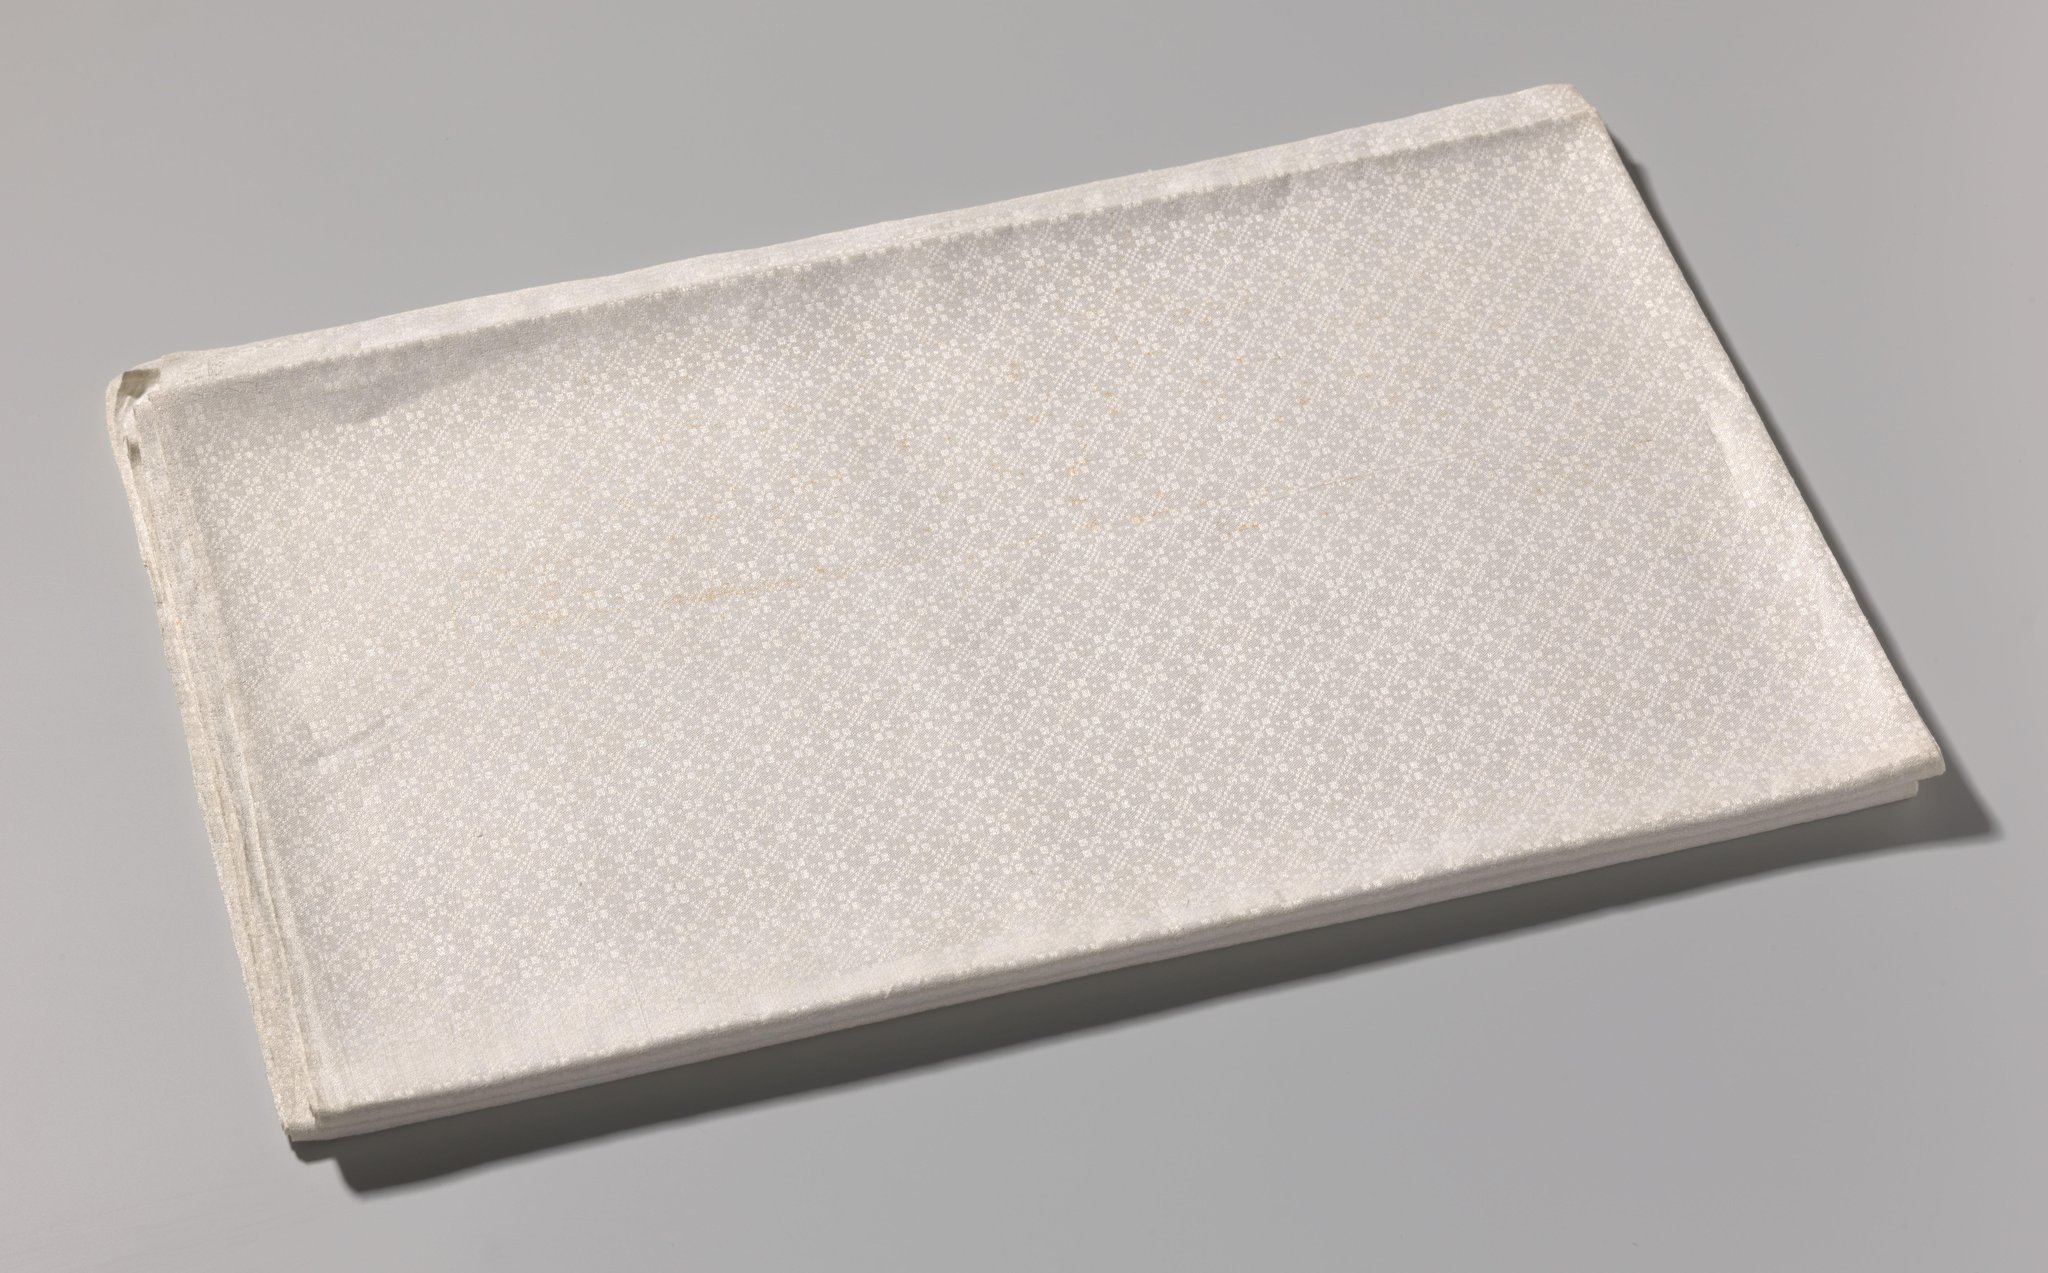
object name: tablecloth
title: Tafellaken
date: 1627-1666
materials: linen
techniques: peeled fabric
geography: northern netherlands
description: Wit linnen tafellaken met een pellen patroon. Merk kroon IVG.